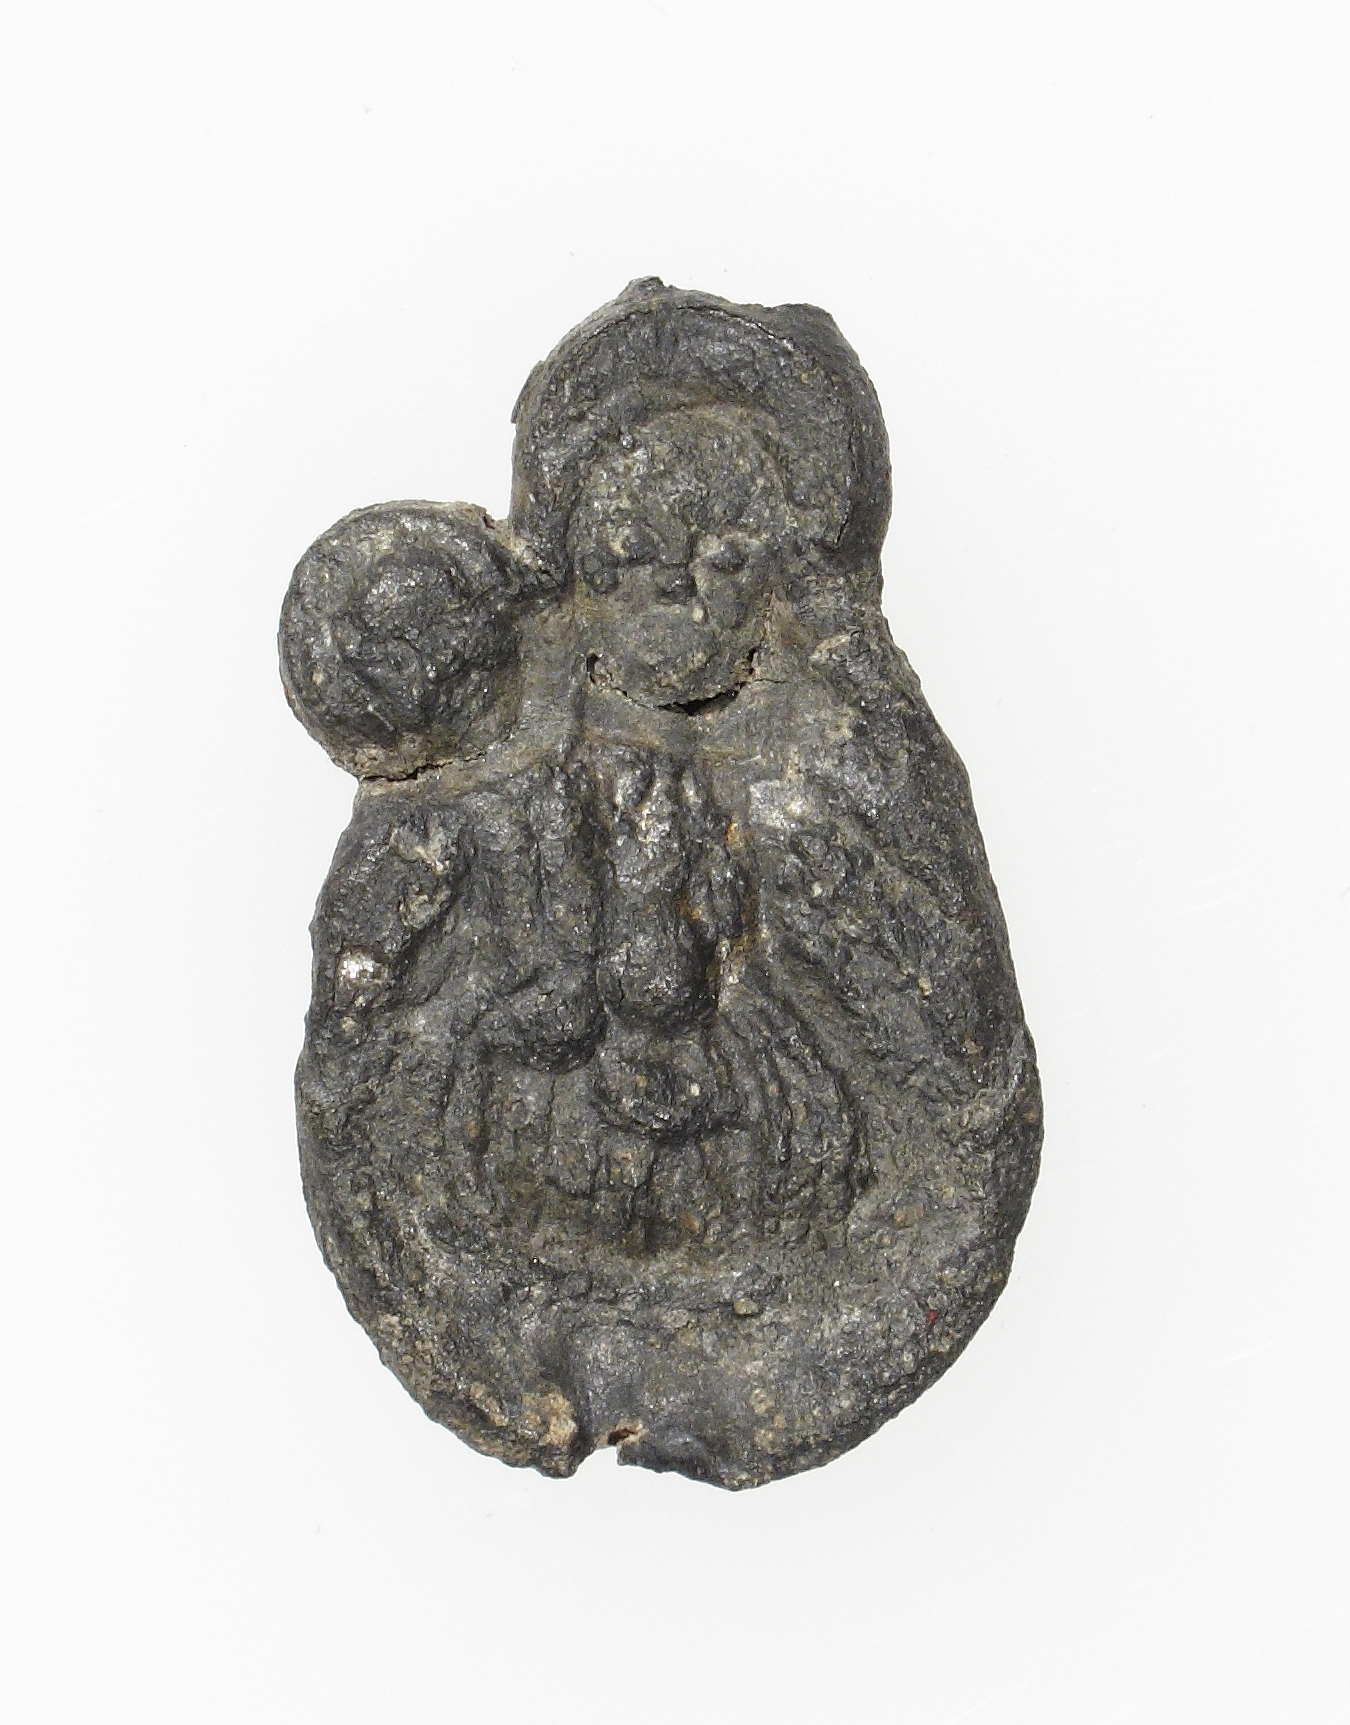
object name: pilgrim's badge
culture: french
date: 1301-1600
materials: lead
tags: madonna and child